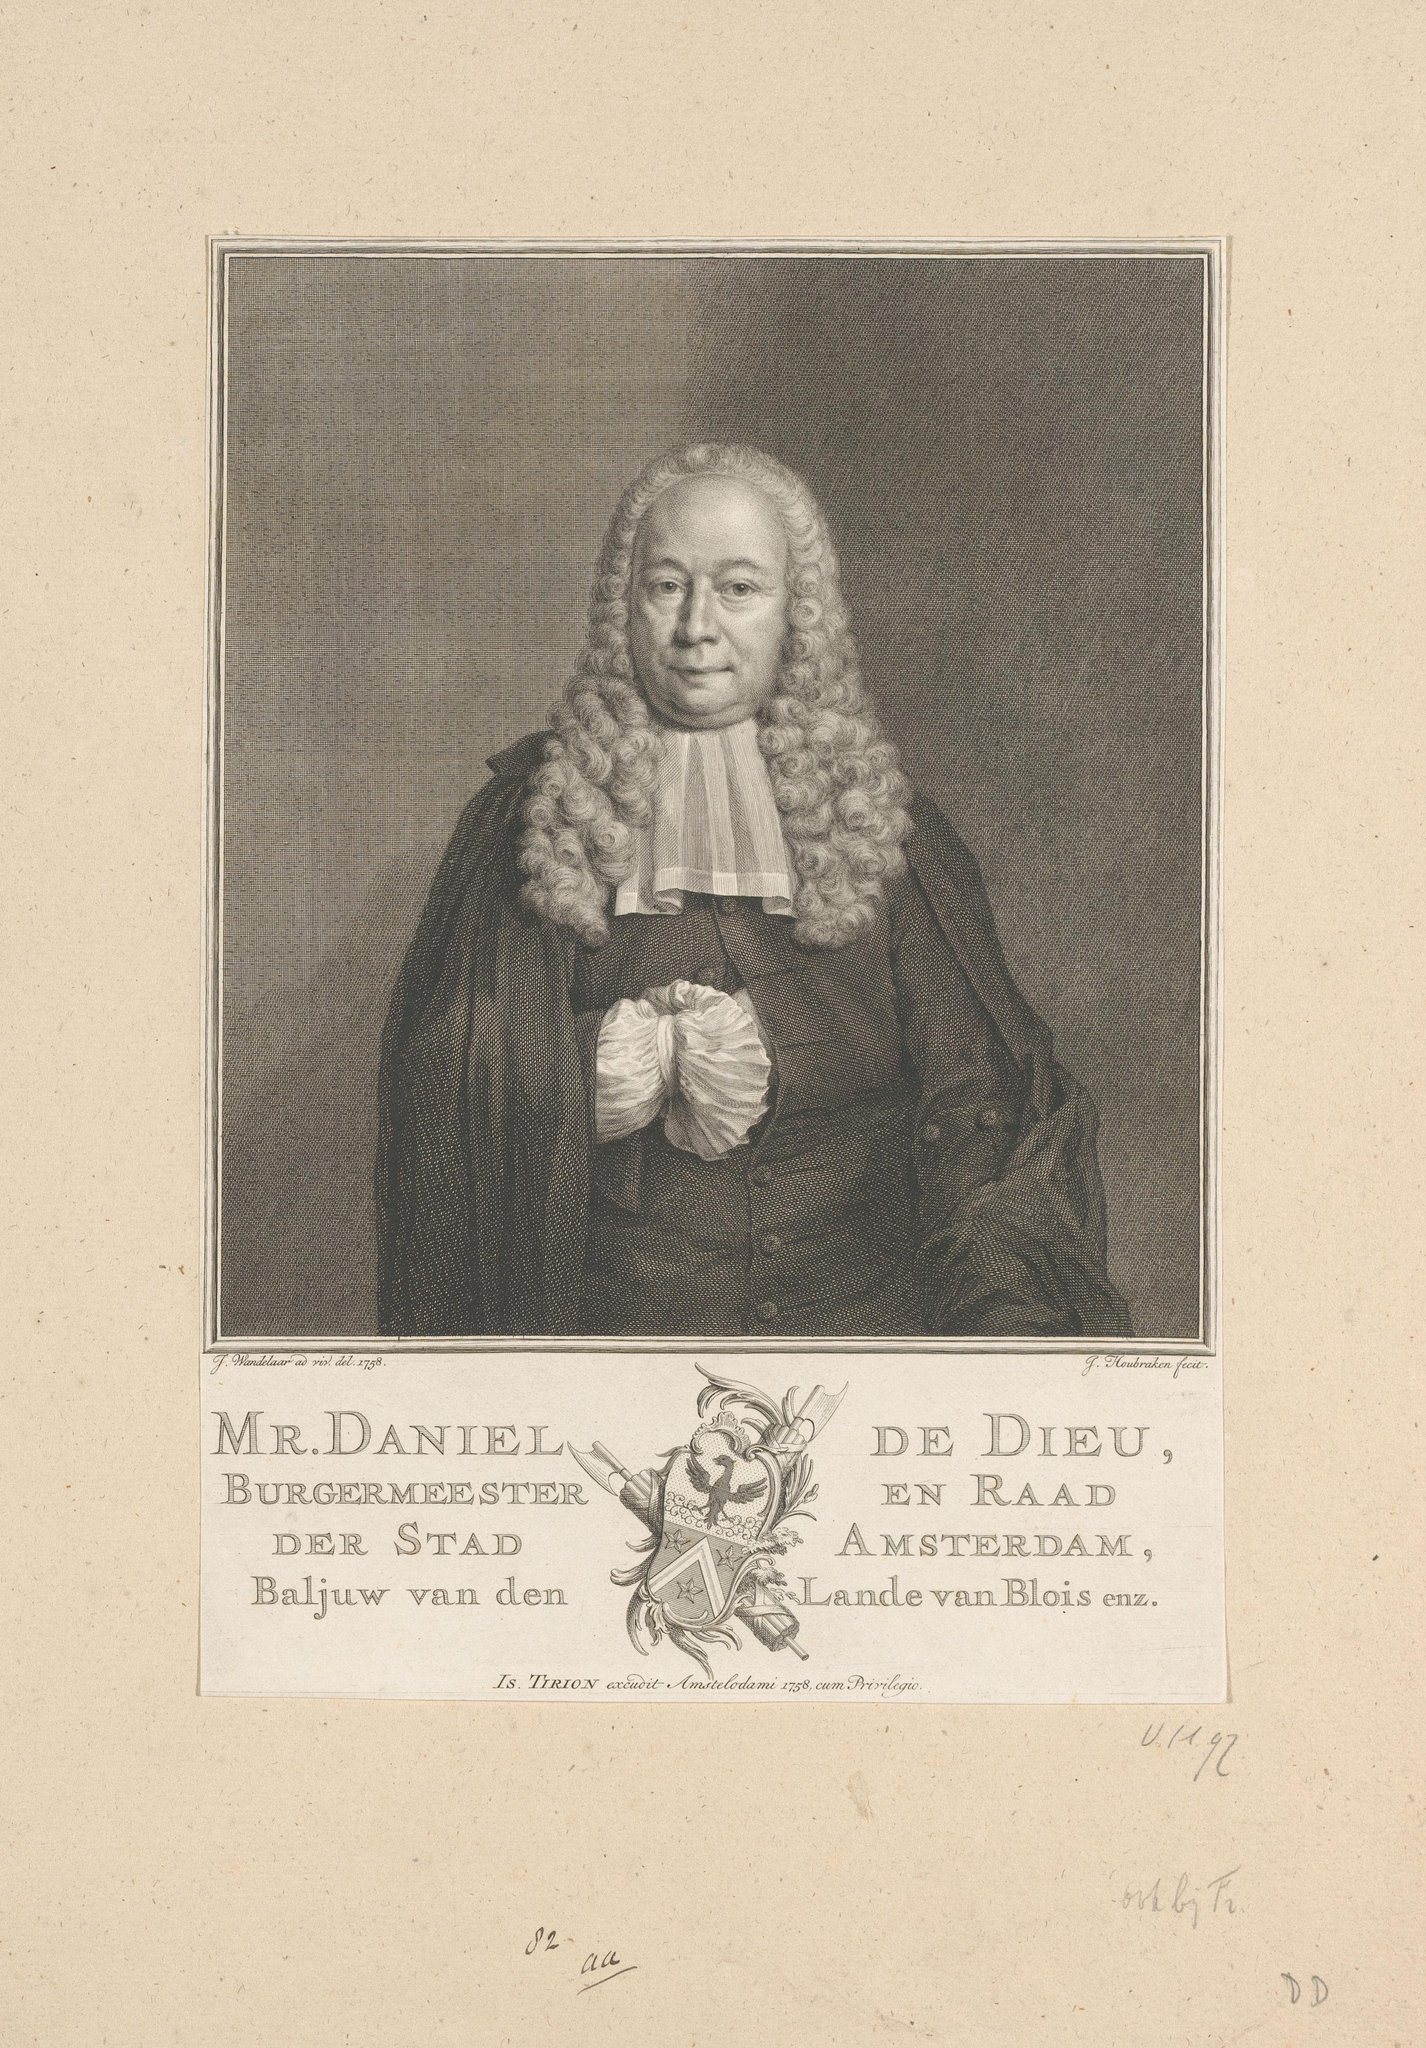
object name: print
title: Portret van Daniel de Dieu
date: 1758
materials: paper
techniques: engraving, etching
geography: amsterdam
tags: mayor, historical persons, armorial bearing, heraldry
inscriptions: collector's mark: Lugt 2228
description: Portret van de Amsterdamse burgemeester Daniel de Dieu. Onder het portret zijn naam en functies in vier regels in het Nederlands, met in het midden zijn wapen.